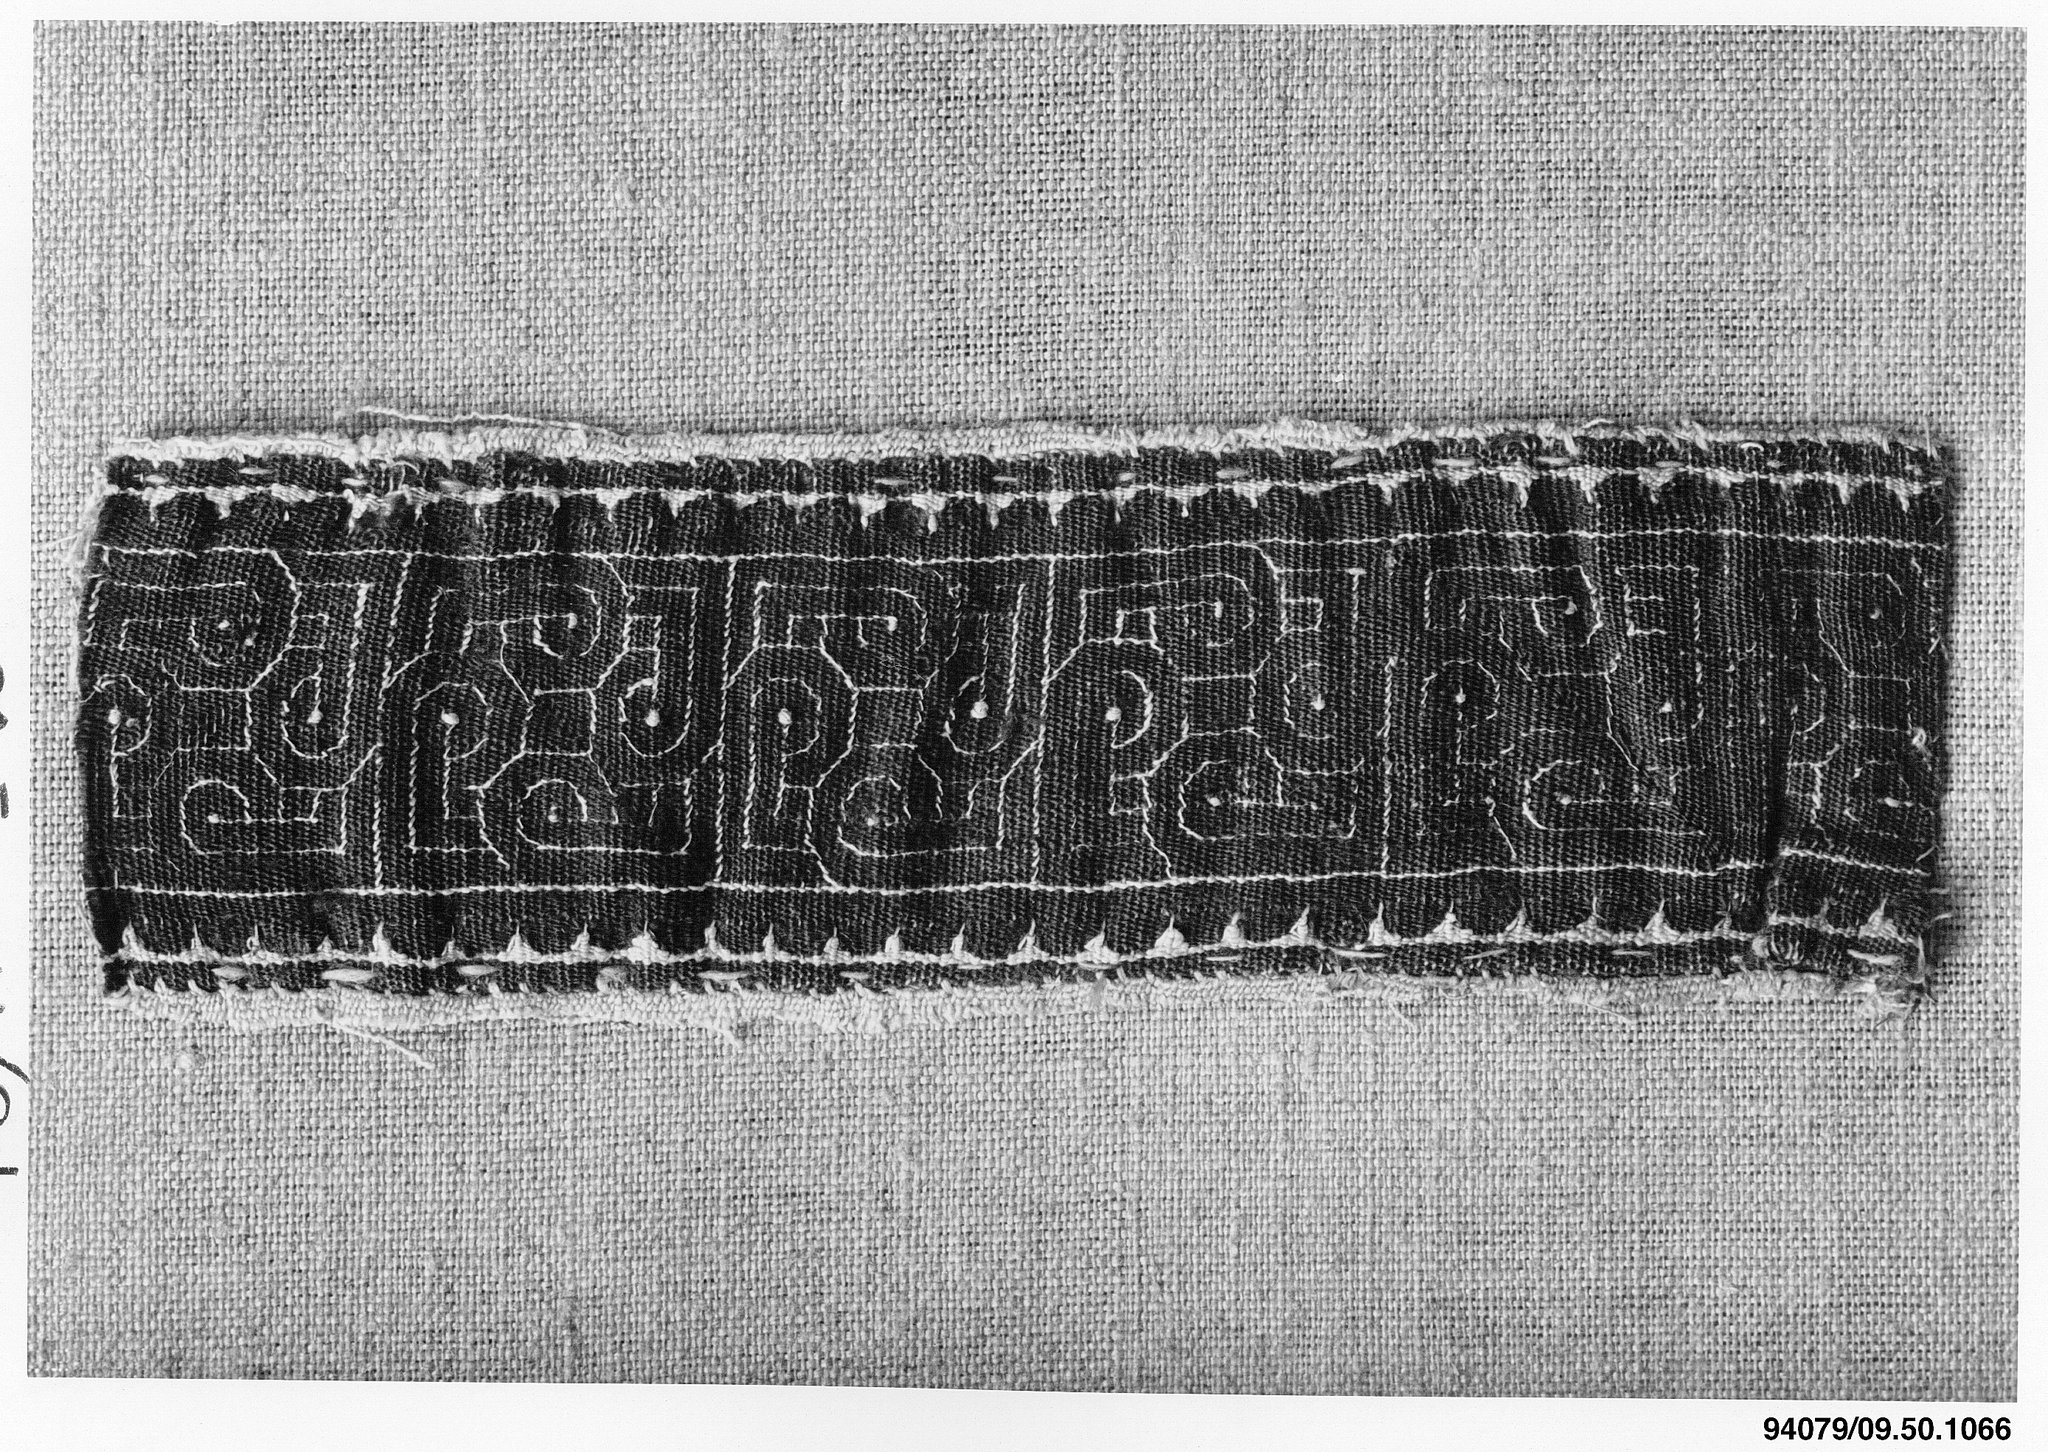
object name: band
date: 201-400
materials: linen, wool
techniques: weave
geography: egypt